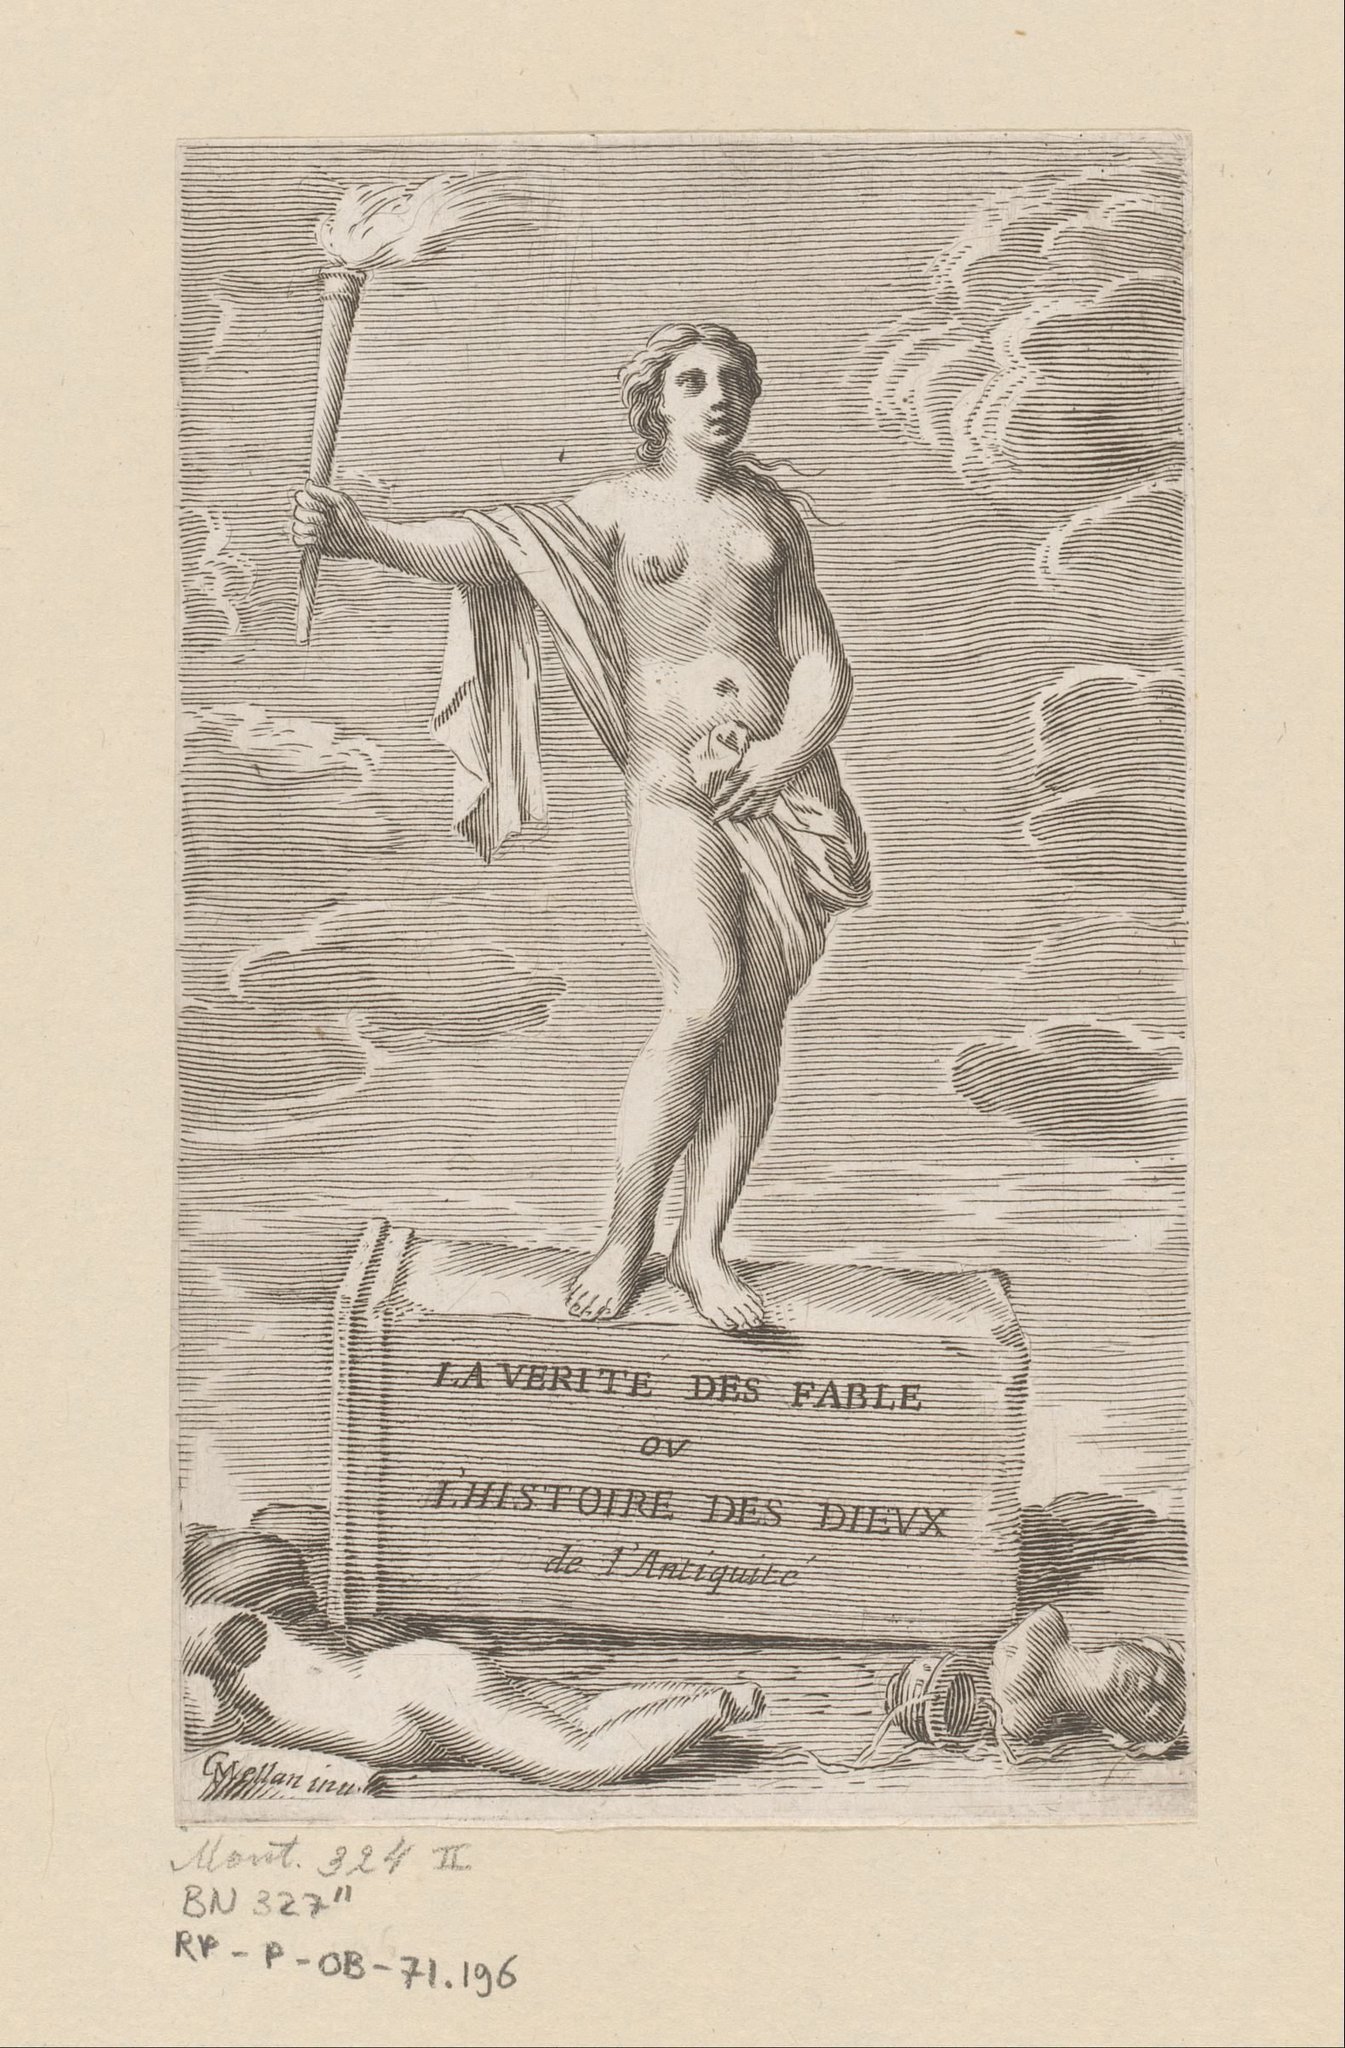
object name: print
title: Naakte vrouw met een toorts op een voetstuk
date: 1648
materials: paper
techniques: engraving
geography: paris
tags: torch, piece of sculpture, reproduction of a piece of sculpture, the (nude) human figure; 'corpo humano' (ripa) - aa - female human figure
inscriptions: collector's mark: Lugt 240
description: Titelpagina voor: Desmarets de Saint-Sorlin, Jean. La Vérité des fables ou l'Histoire des dieux de l'antiquité. Parijs: Henri Le Gras, 1648.